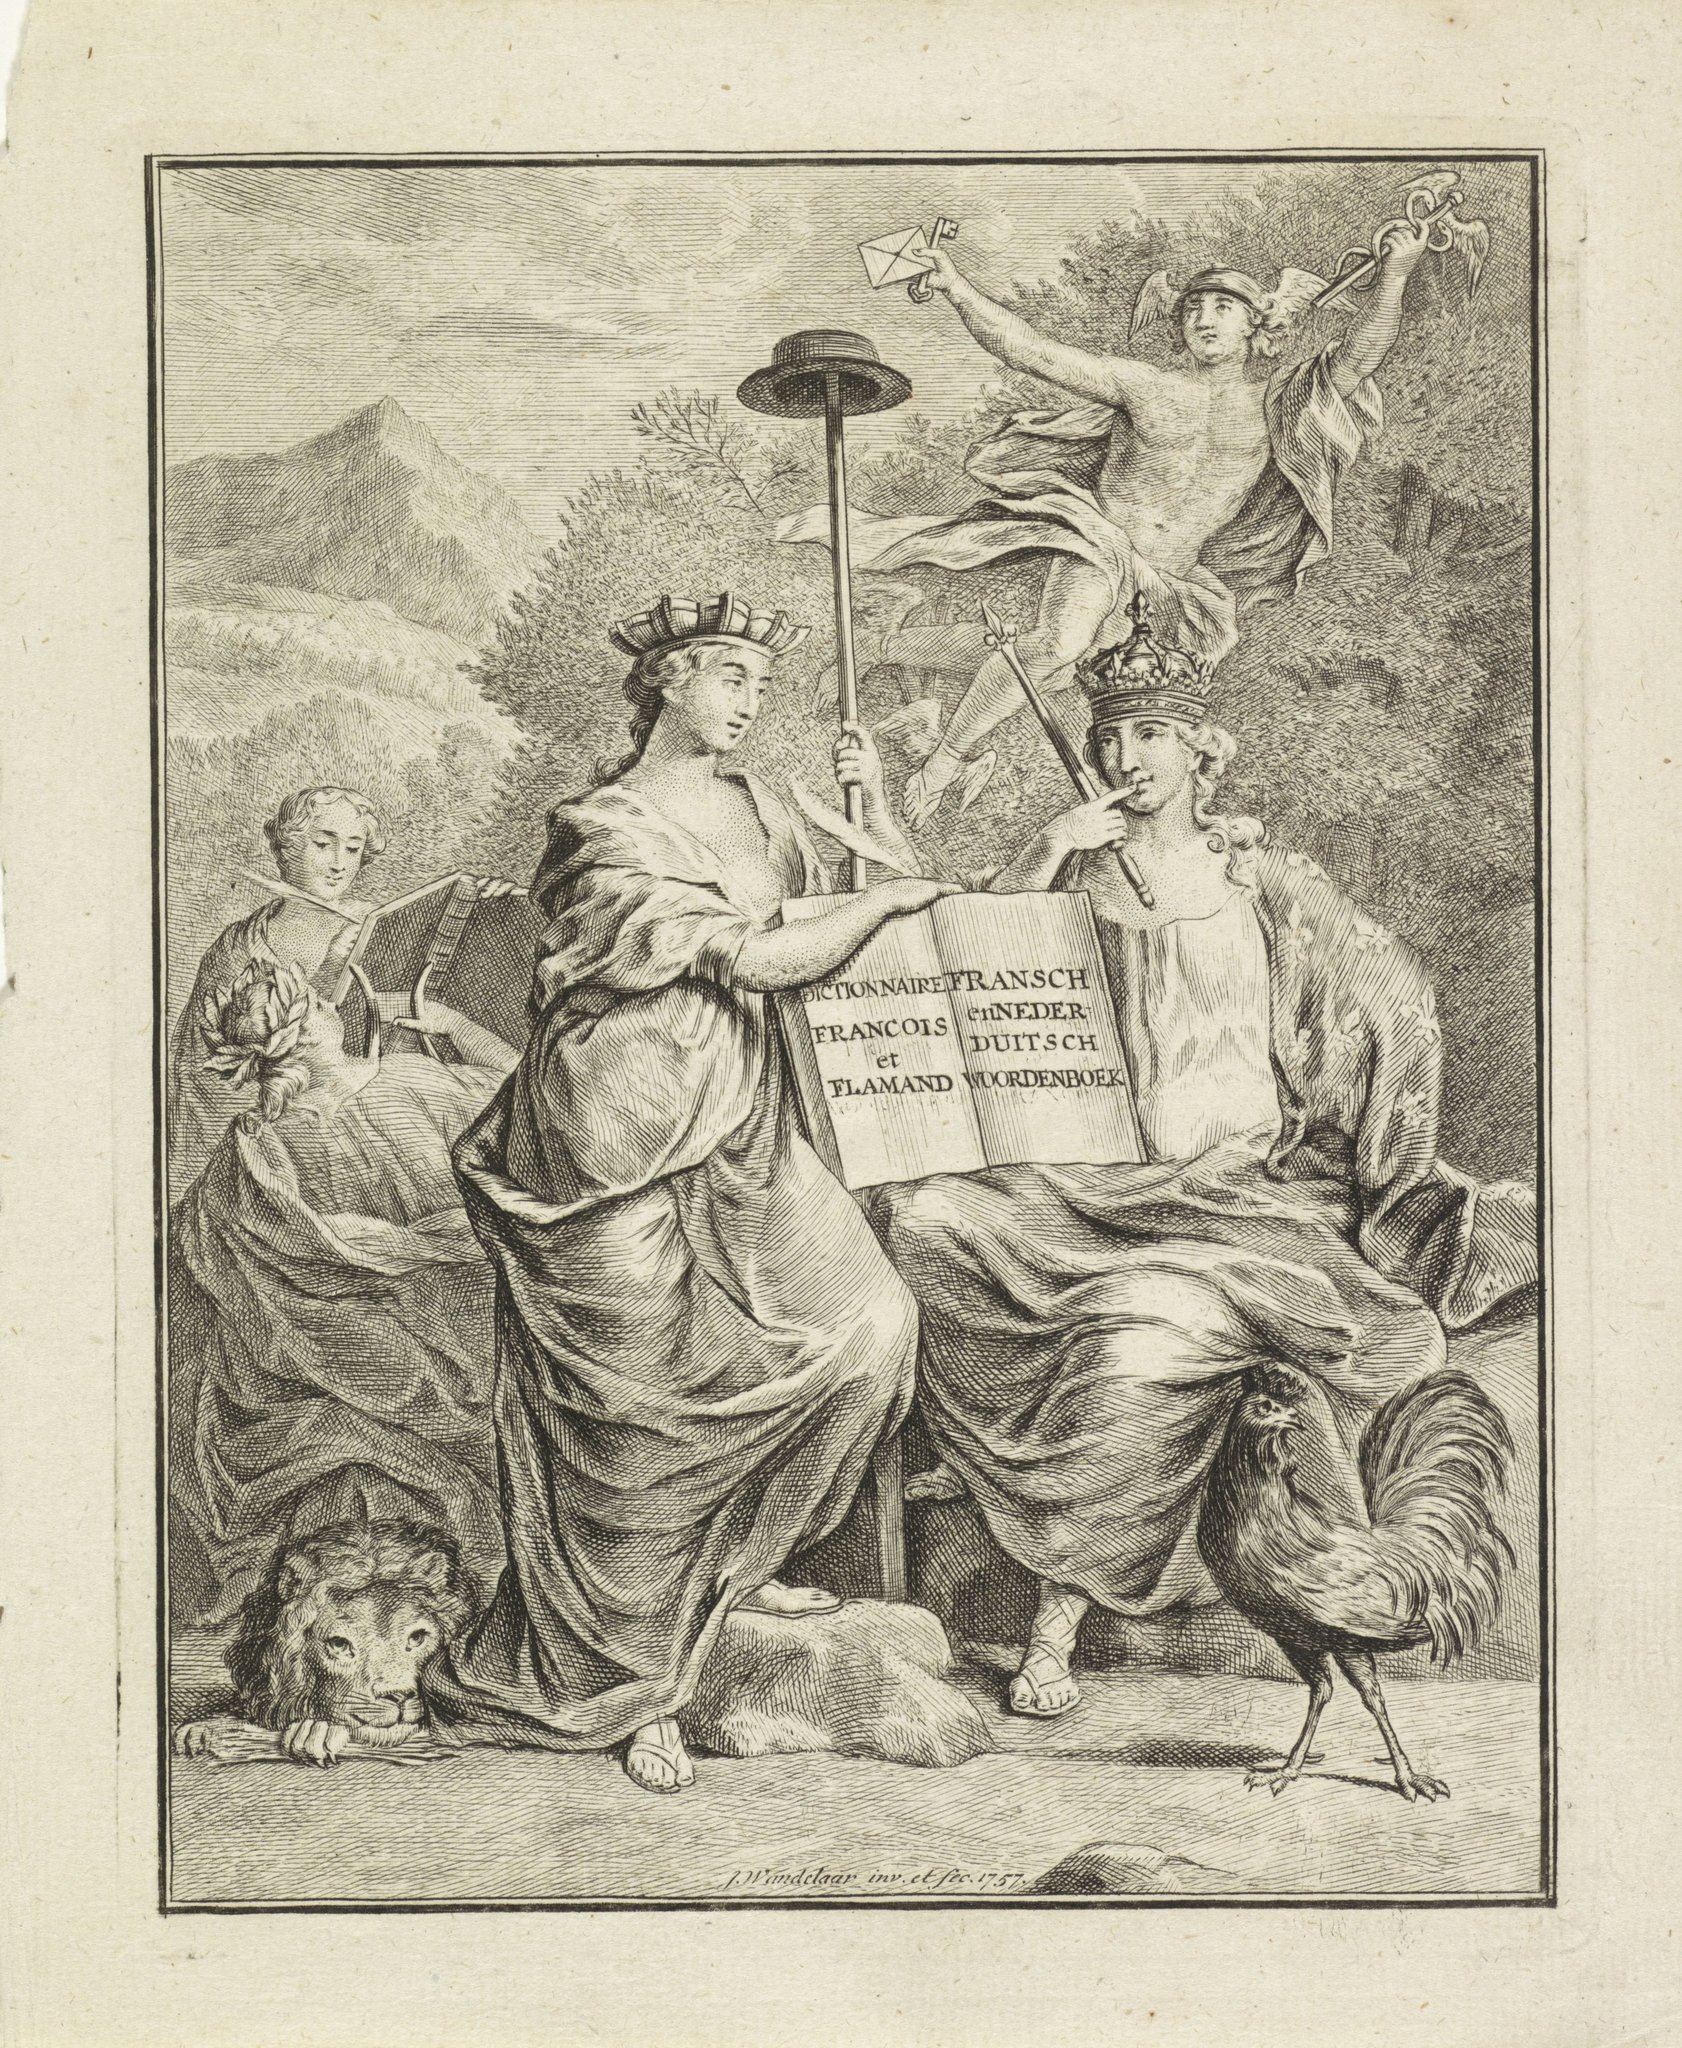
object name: print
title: Titelpagina voor: Halma, François. Het groot Fransch en Nederduitsch woordenboek (...)1761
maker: jan wandelaar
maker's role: draughtsman, print maker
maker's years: 1690-1759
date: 1757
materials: paper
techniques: engraving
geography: northern netherlands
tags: personifications of countries, nations, states, districts, etc., title-page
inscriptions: collector's mark: Lugt 2228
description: In het midden zit de personificatie van de Oostenrijkse Nederlanden met een muurkroon en een vrijheidsstaf met hoed. Ze houdt een opengeslagen boek vast met de verkorte titel. Aan haar voeten ligt een leeuw met een pijlenbundel. Links achter haar bespeelt een vrouw een harp en schrijft een andere vrouw in een boek. Aan de andere kant van het opengeslagen boek zit de personificatie van Frankrijk met een kroon, een scepter en een haan aan haar voeten. Achter hen vliegt Mercurius met zijn caduceus, een envelop en een sleutel.